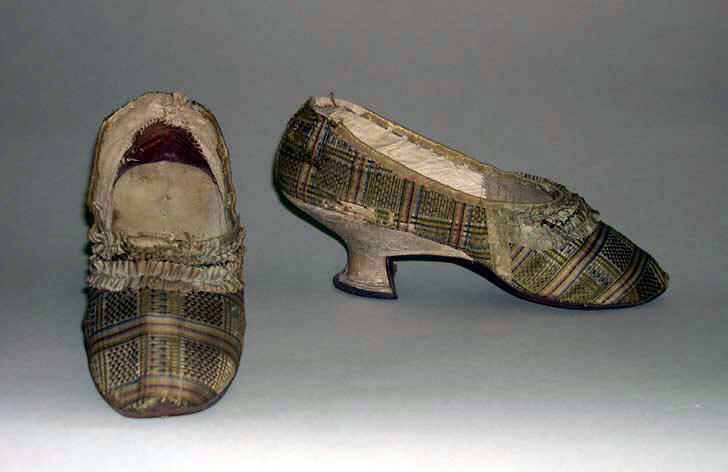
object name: slipper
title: Slippers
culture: american or european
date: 1780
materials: silk